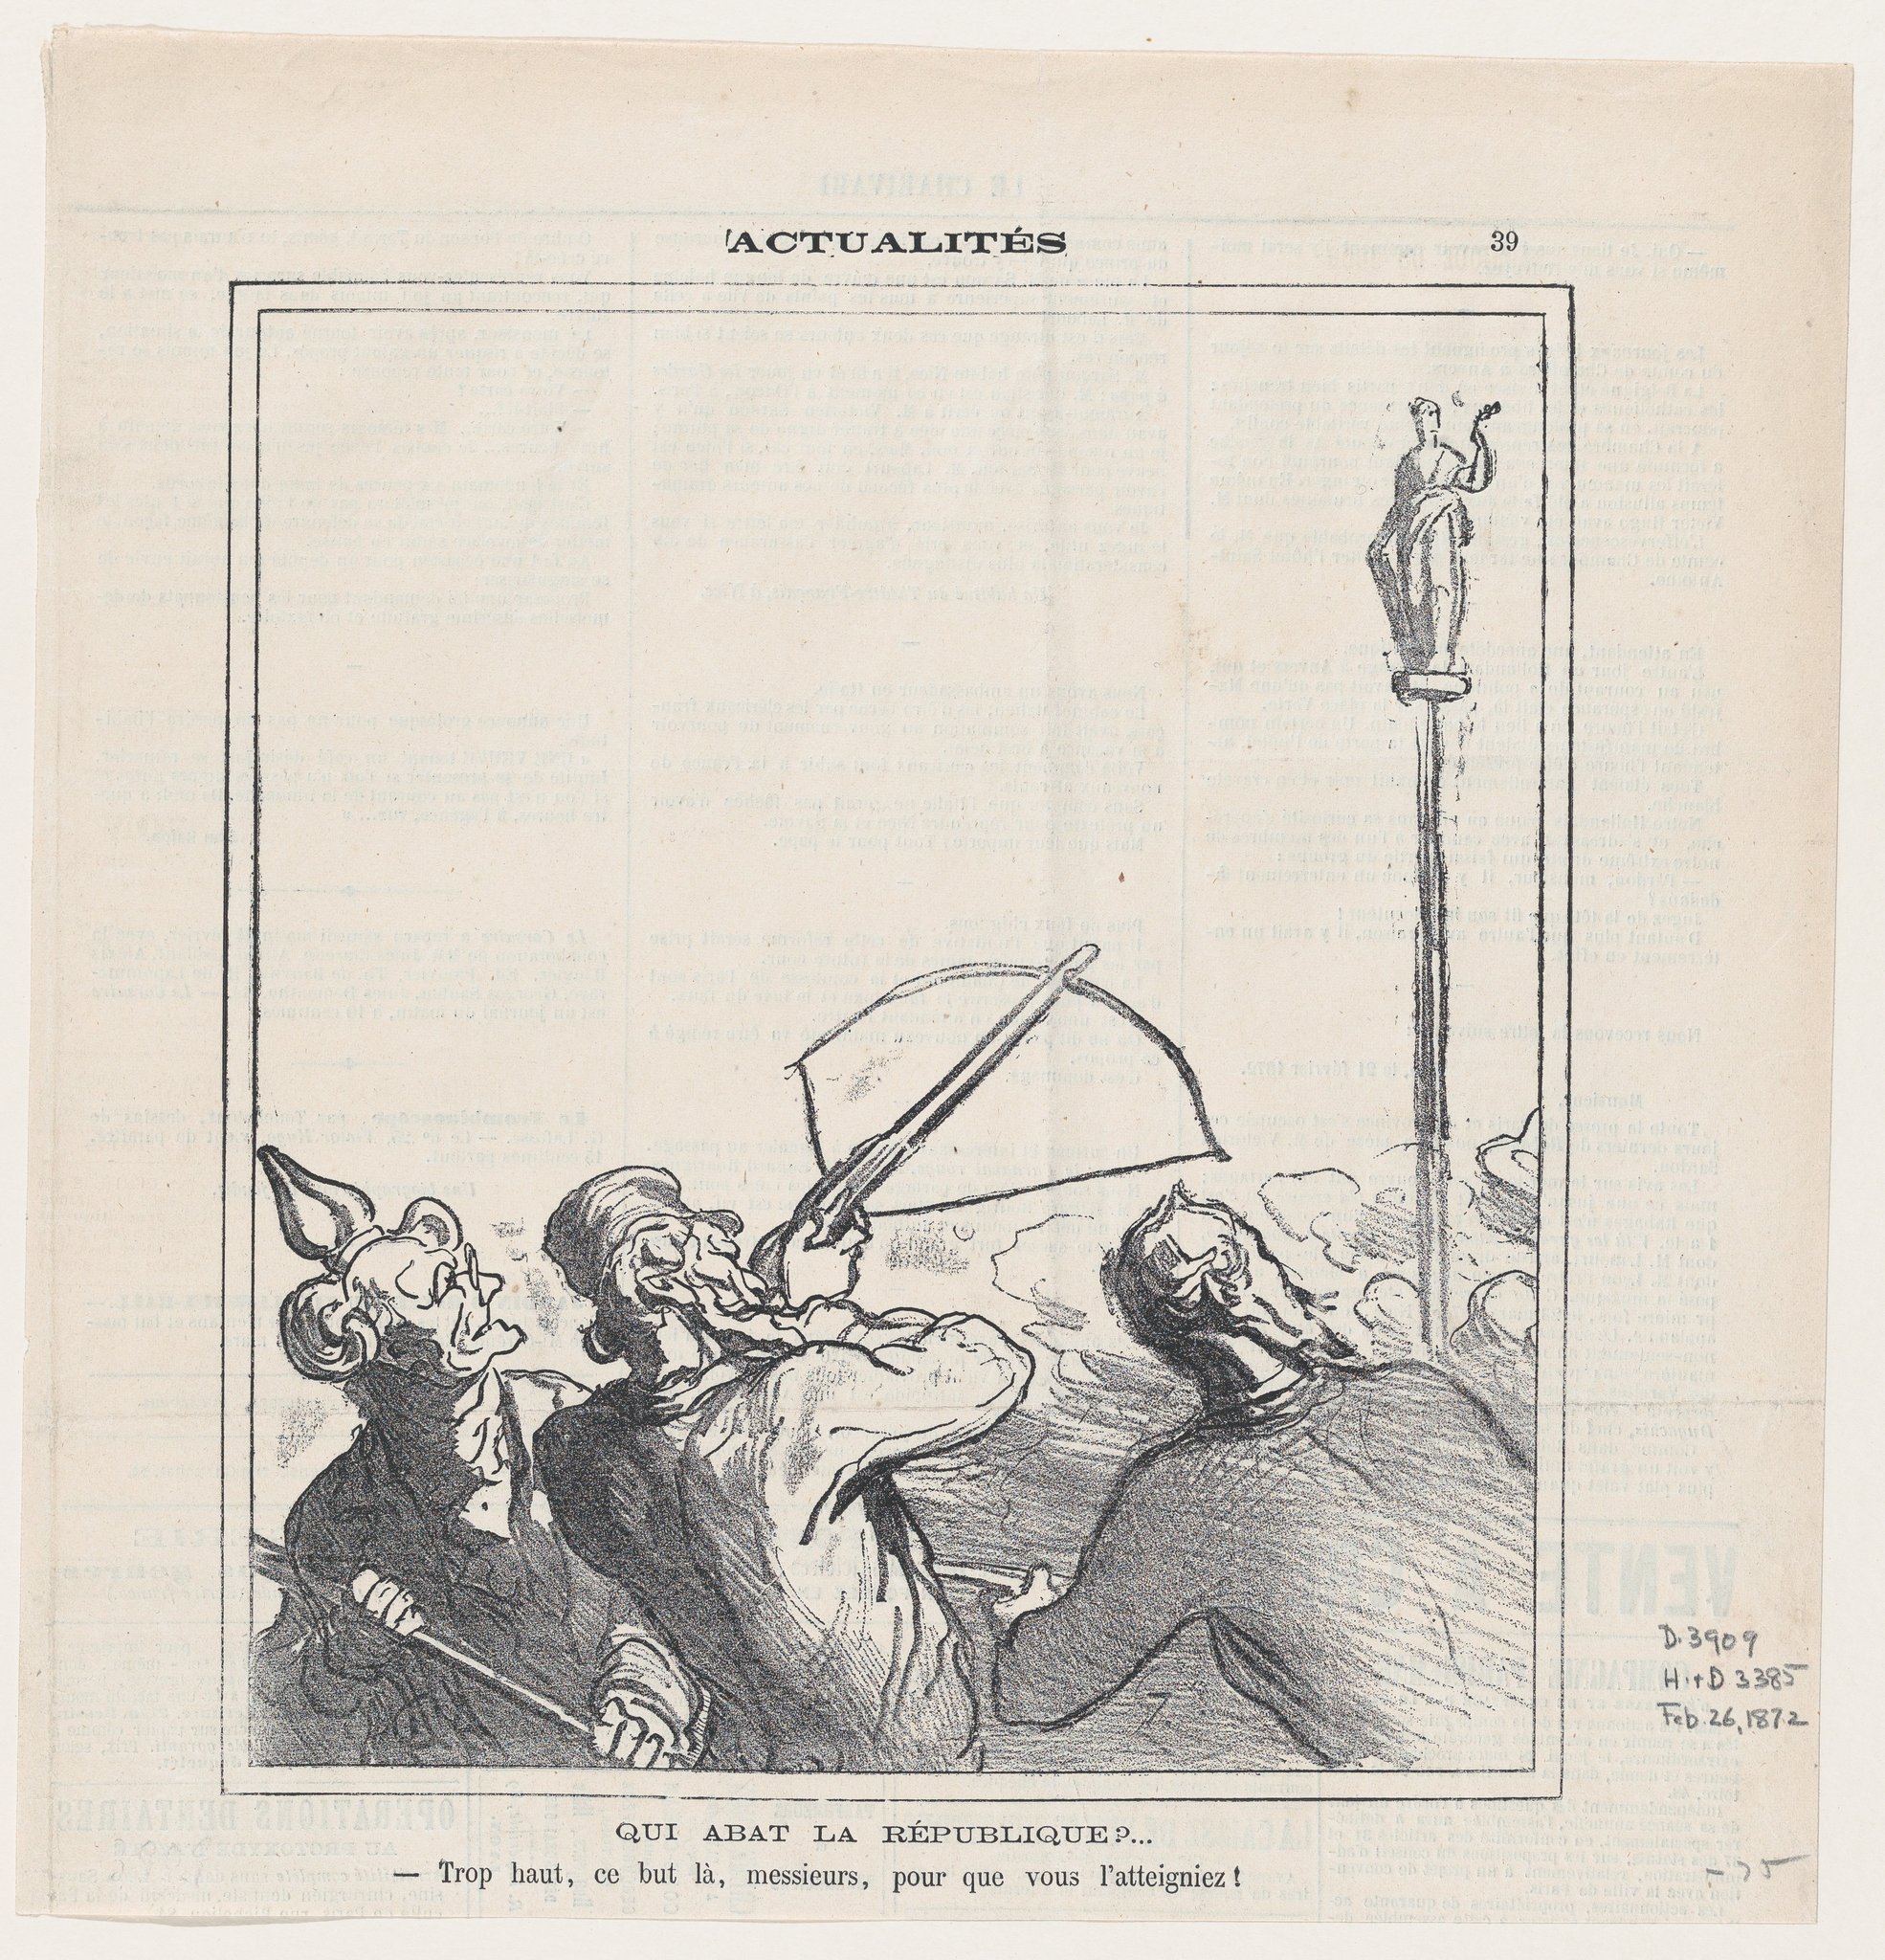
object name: print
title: Who will shoot down the Republic? –Gentlemen, this mark is too high for you to be able to reach it!, from 'News of the day,' published in Le Charivari, February 26, 1872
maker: honoré daumier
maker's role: artist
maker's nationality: french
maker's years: 1808-1879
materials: paper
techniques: lithograph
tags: bow and arrow,men